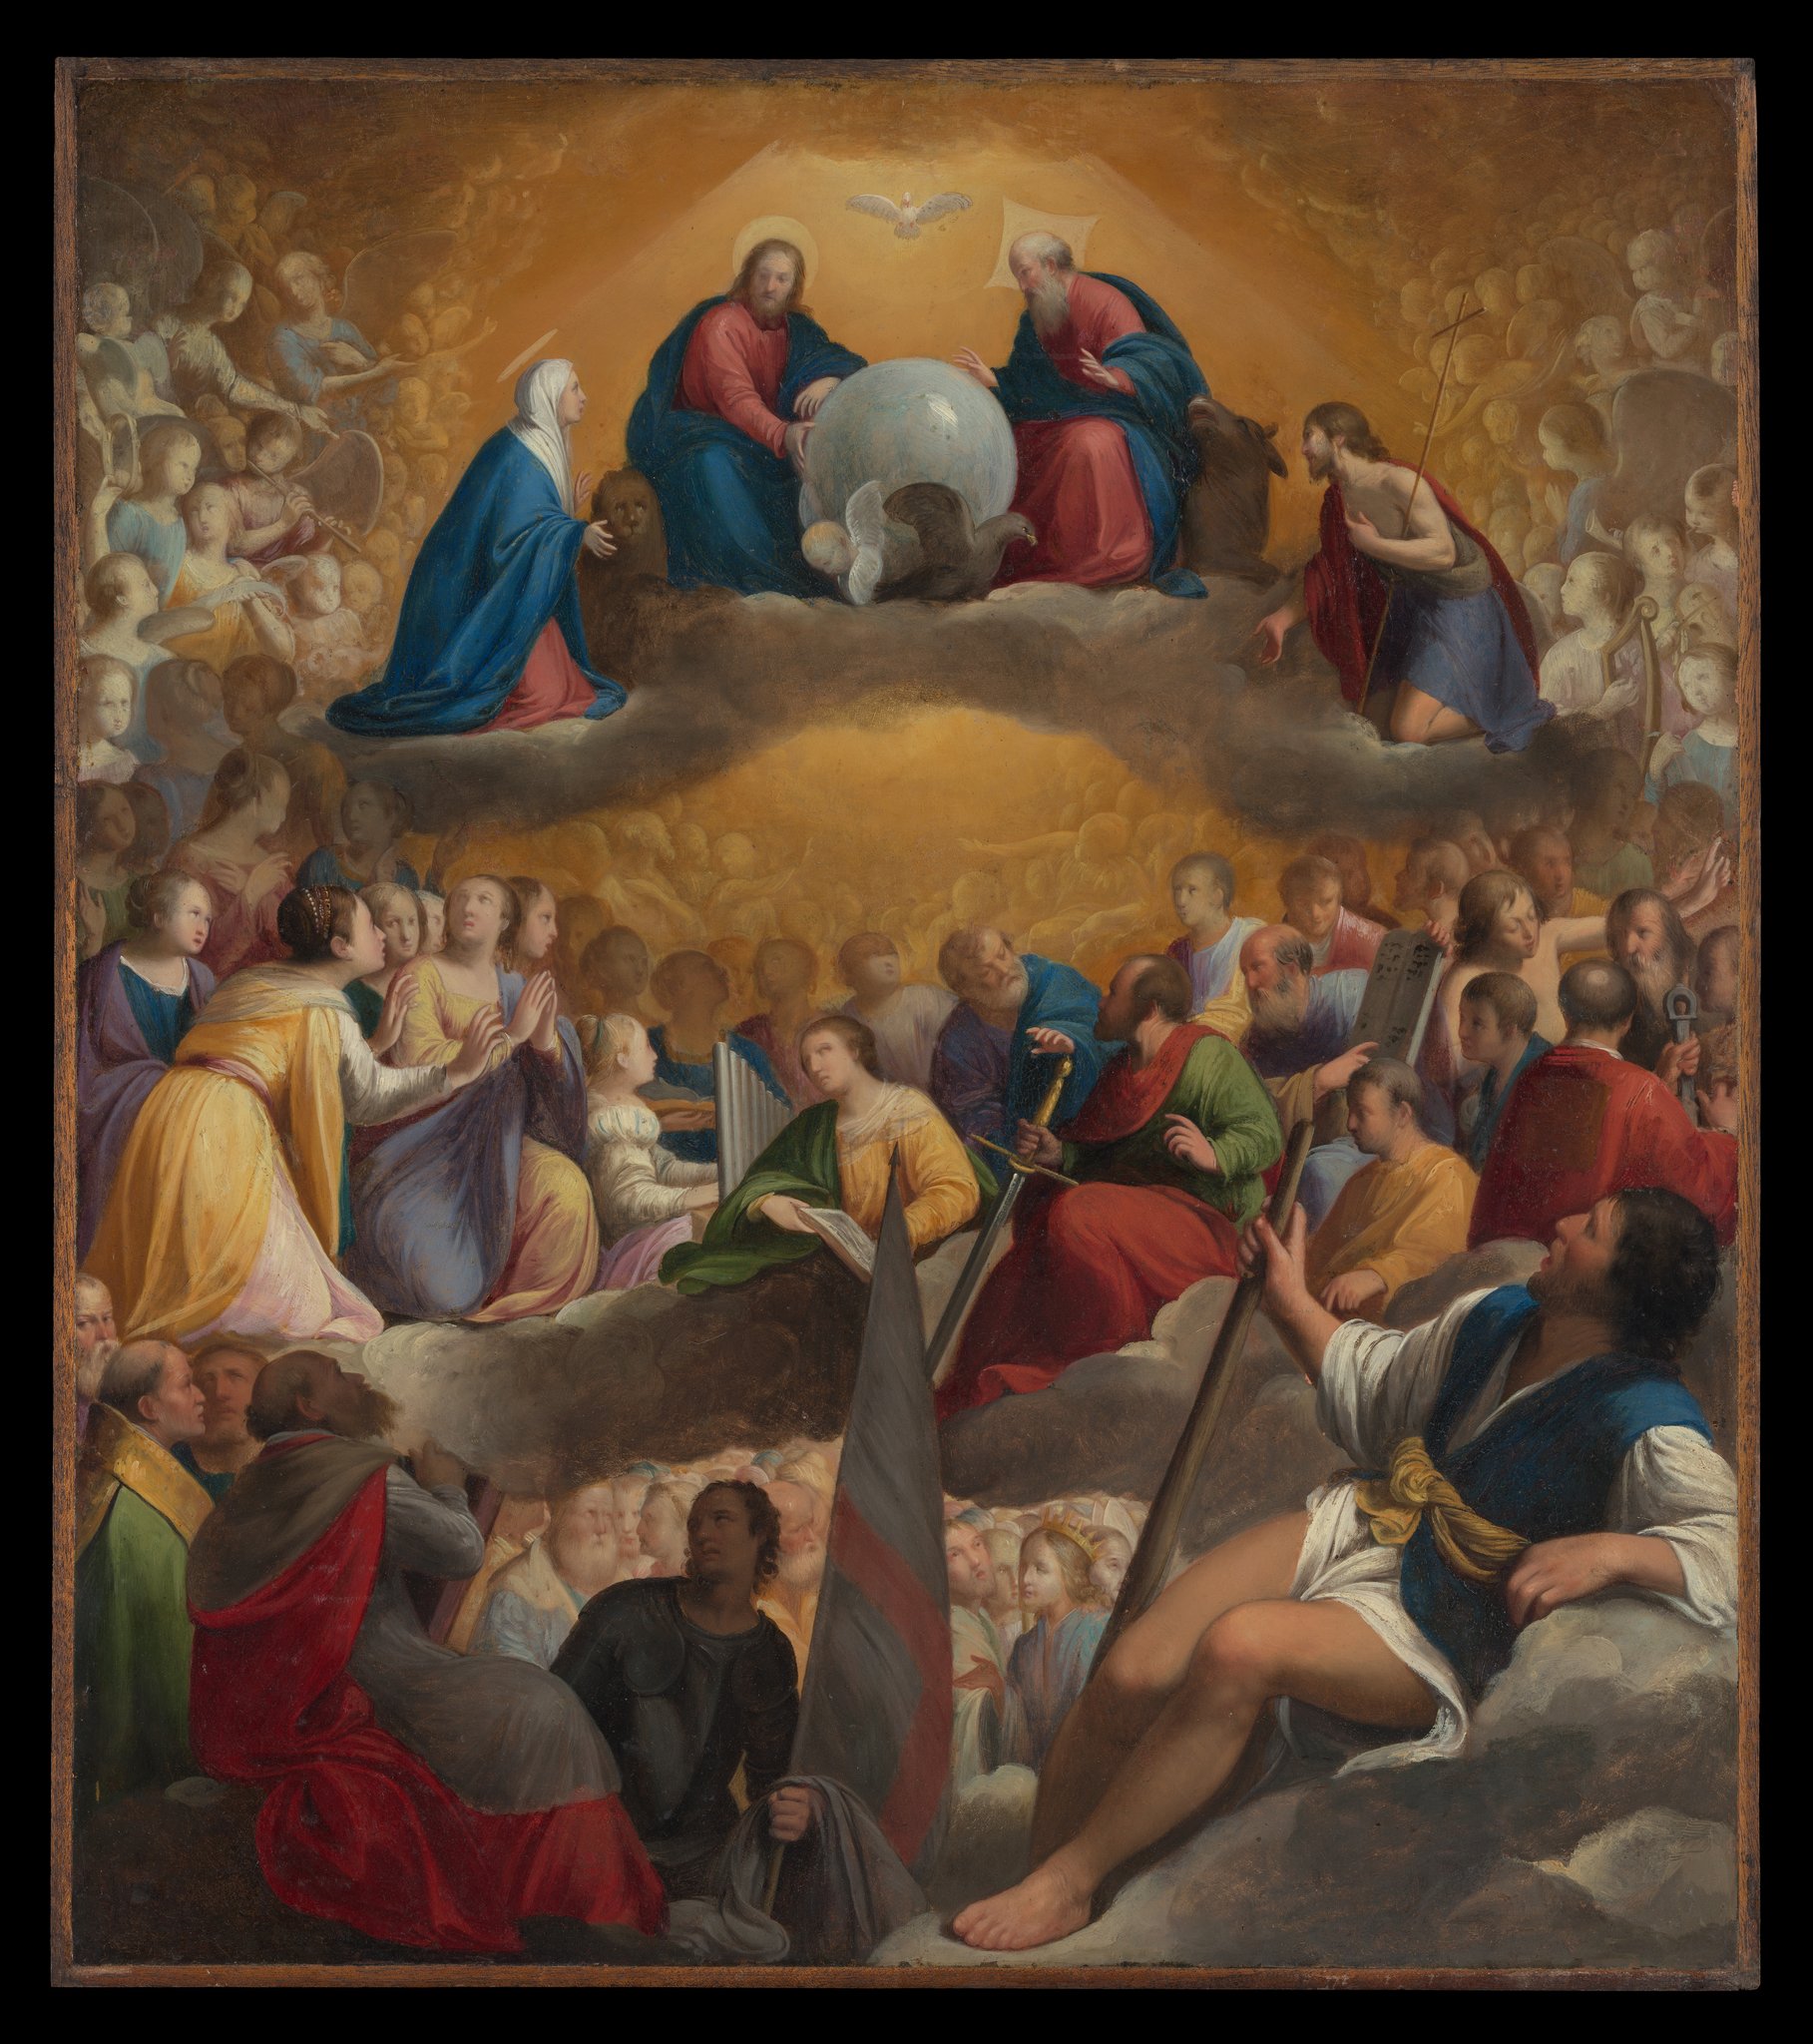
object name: painting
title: Paradise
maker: carlo saraceni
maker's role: artist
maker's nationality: italian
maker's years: 1579-1620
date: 1598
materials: copper, oil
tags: saint george,saint john the baptist,virgin mary,jesus